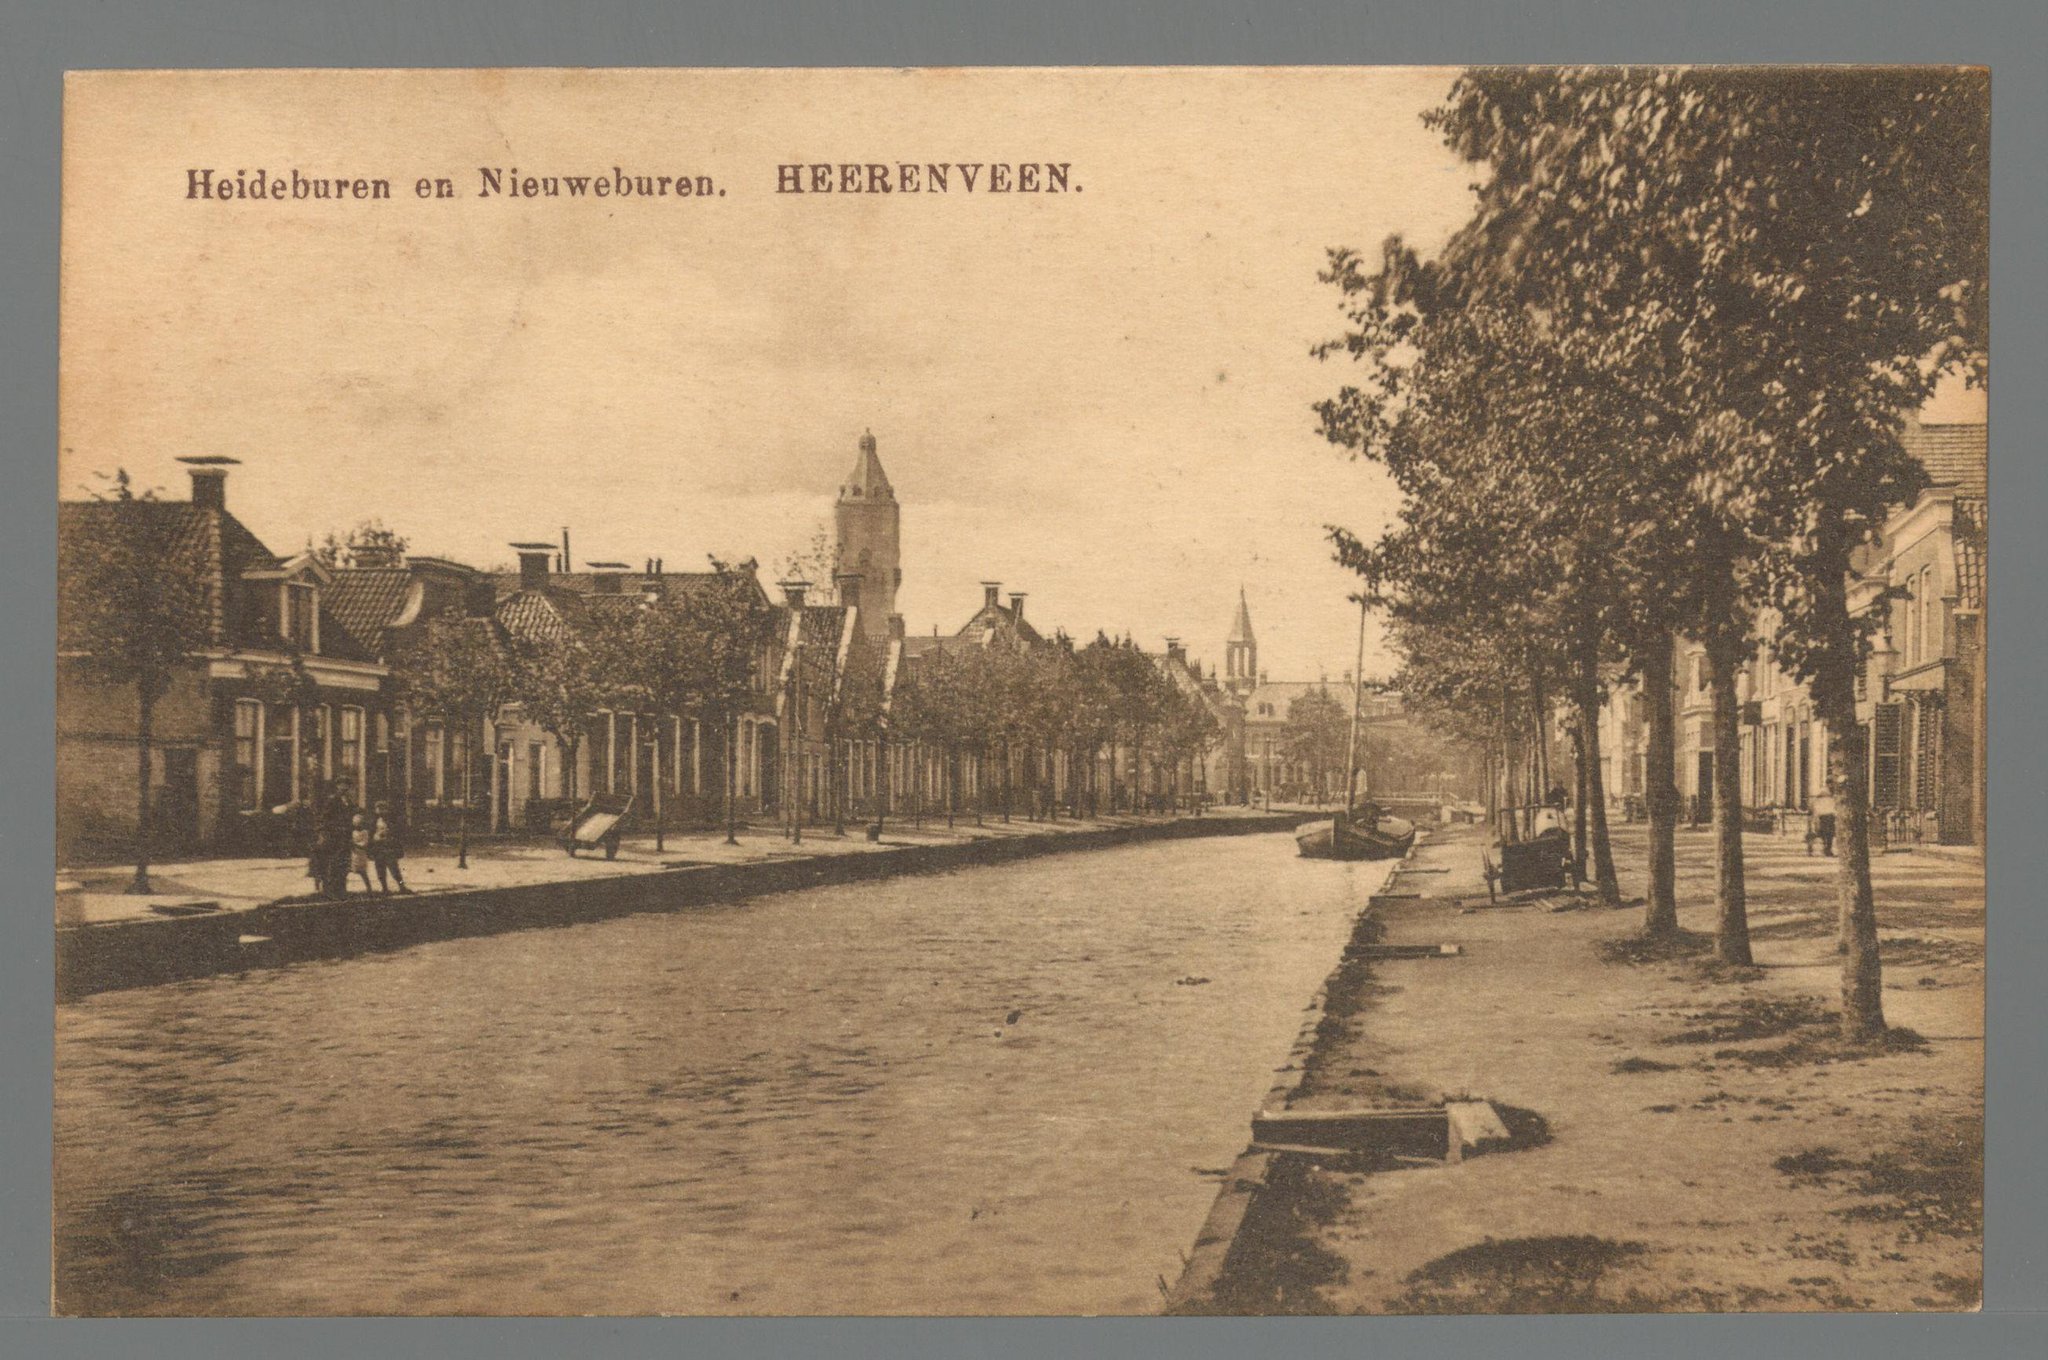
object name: ansichtkaart, prentbriefkaart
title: Heideburen en Nieuweburen. Heerenveen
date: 1905-1908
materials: cardboard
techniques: photograph, writing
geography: heerenveen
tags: canal, street, parts of church exterior and annexes: tower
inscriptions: postage stamp